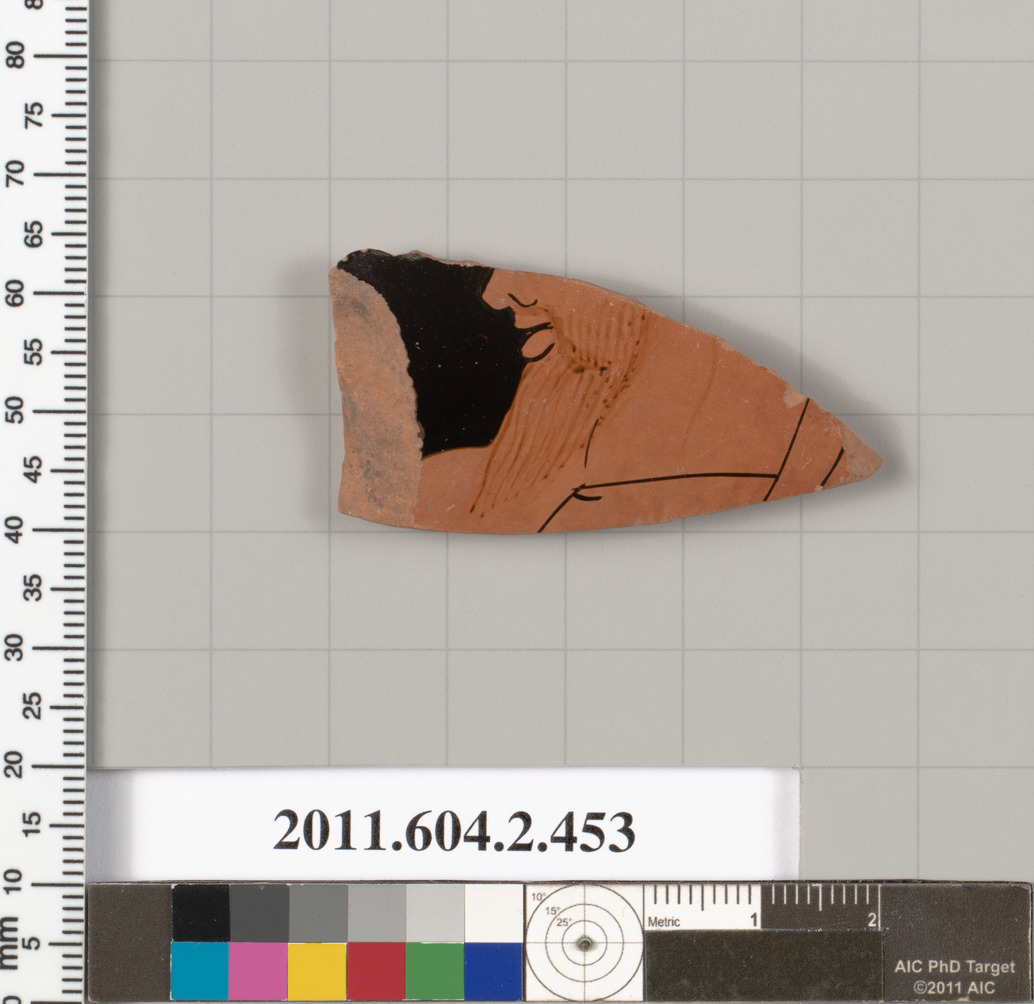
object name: column krater fragment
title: Terracotta fragment of a column-krater (bowl for mixing wine and water)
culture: greek, attic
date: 490-470 BCE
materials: terracotta